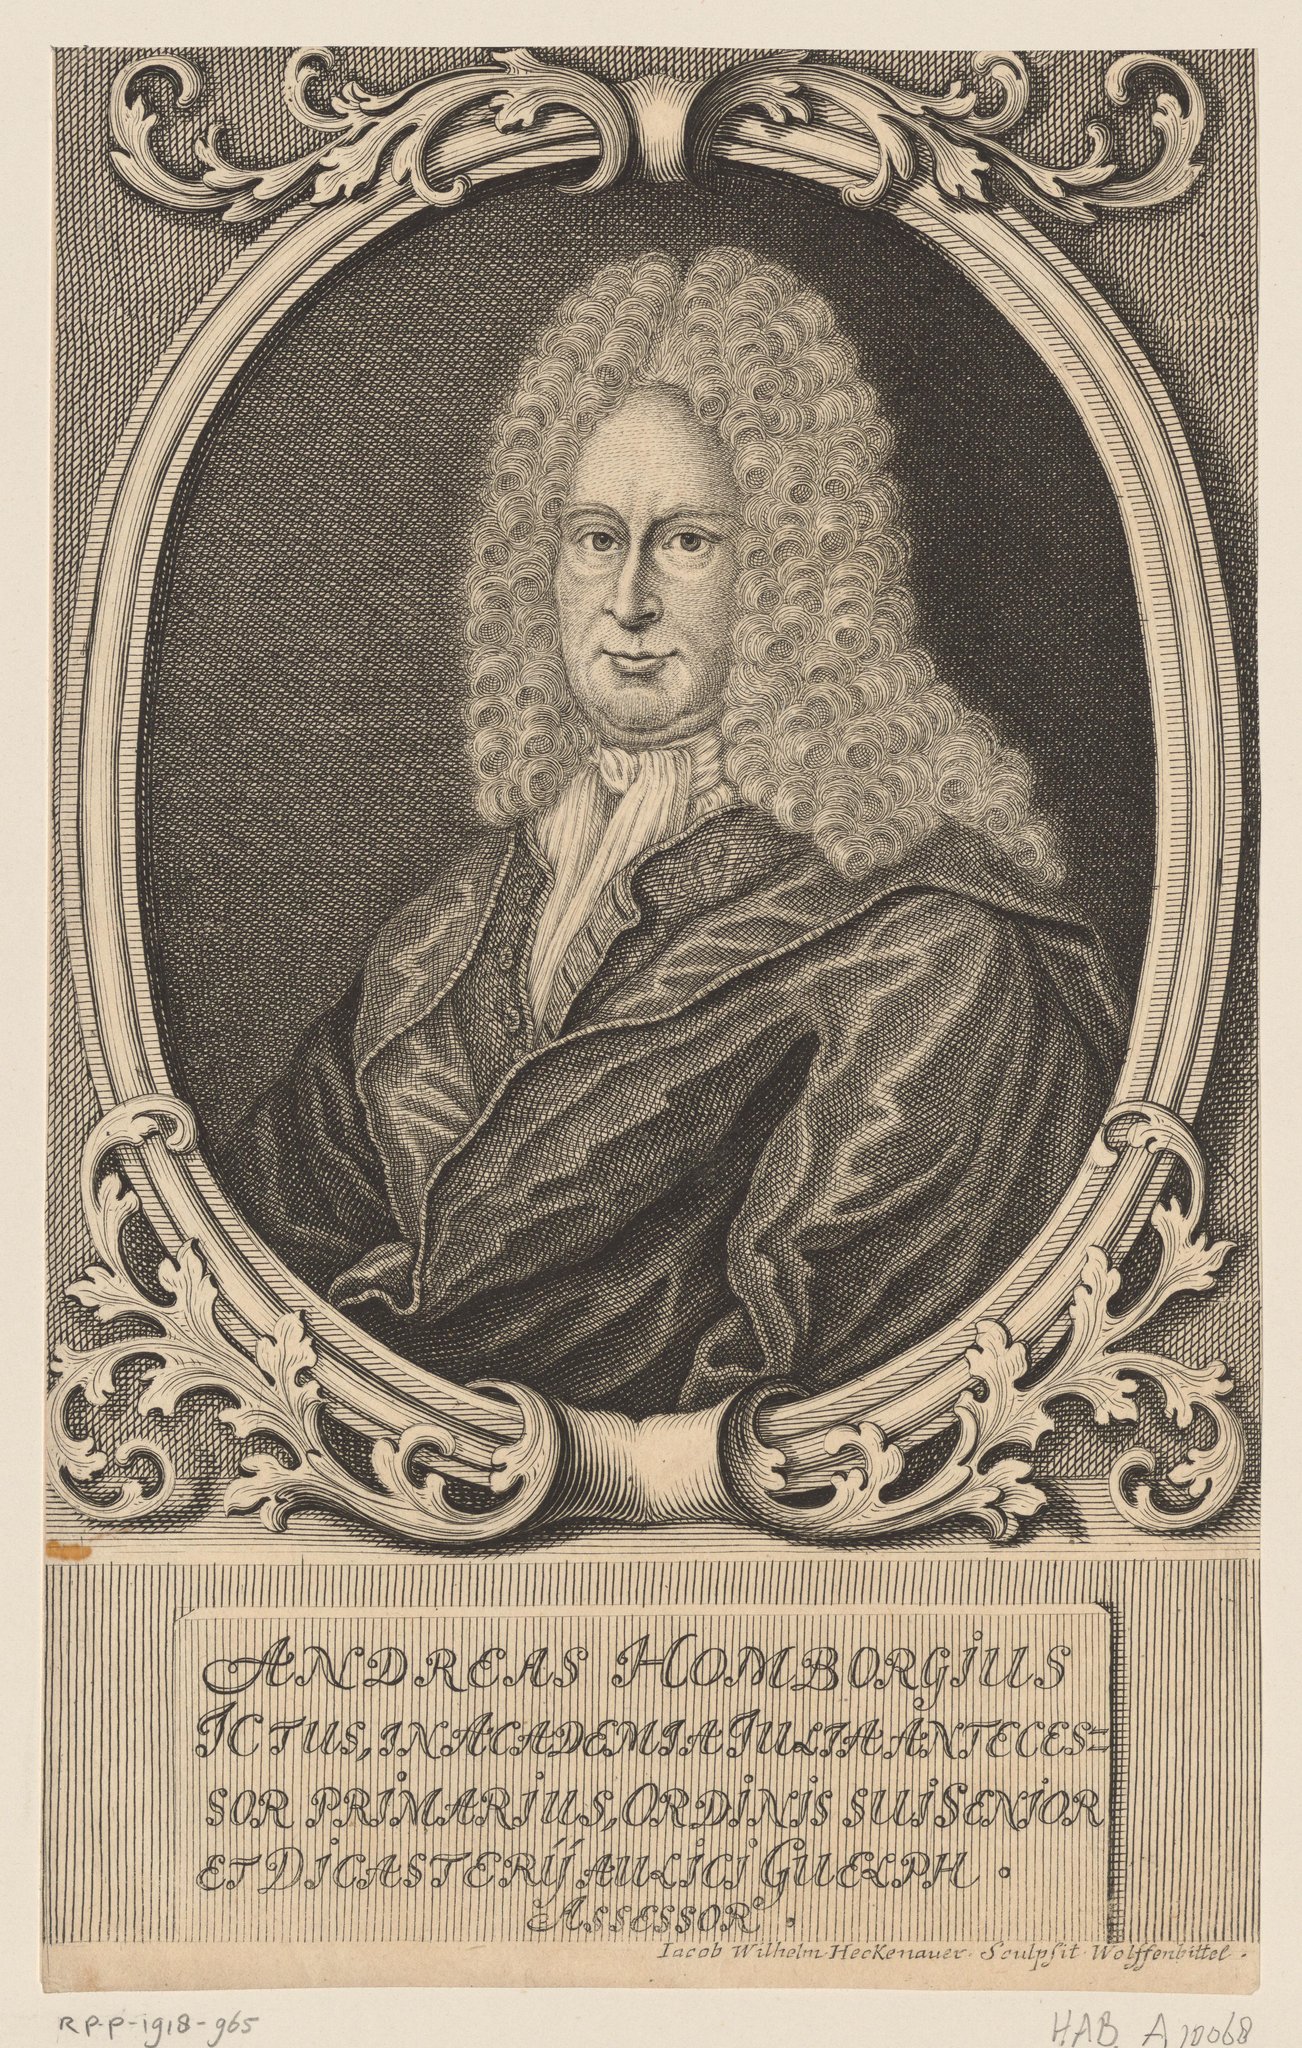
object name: book illustration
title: Portret van Andreas Homborg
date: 1713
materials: paper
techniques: engraving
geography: wolfenbüttel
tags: acanthus ~ ornament - aa - stylized, ornament ~ medallion, adult man, historical persons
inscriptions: collector's mark: Lugt 2233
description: Prent uit: Homborg, Andreas. Consilia sive Responsa Helmstadiensia (...). Frankfurt am Main en Leipzig: Johann Melchior Süstermann, 1713.